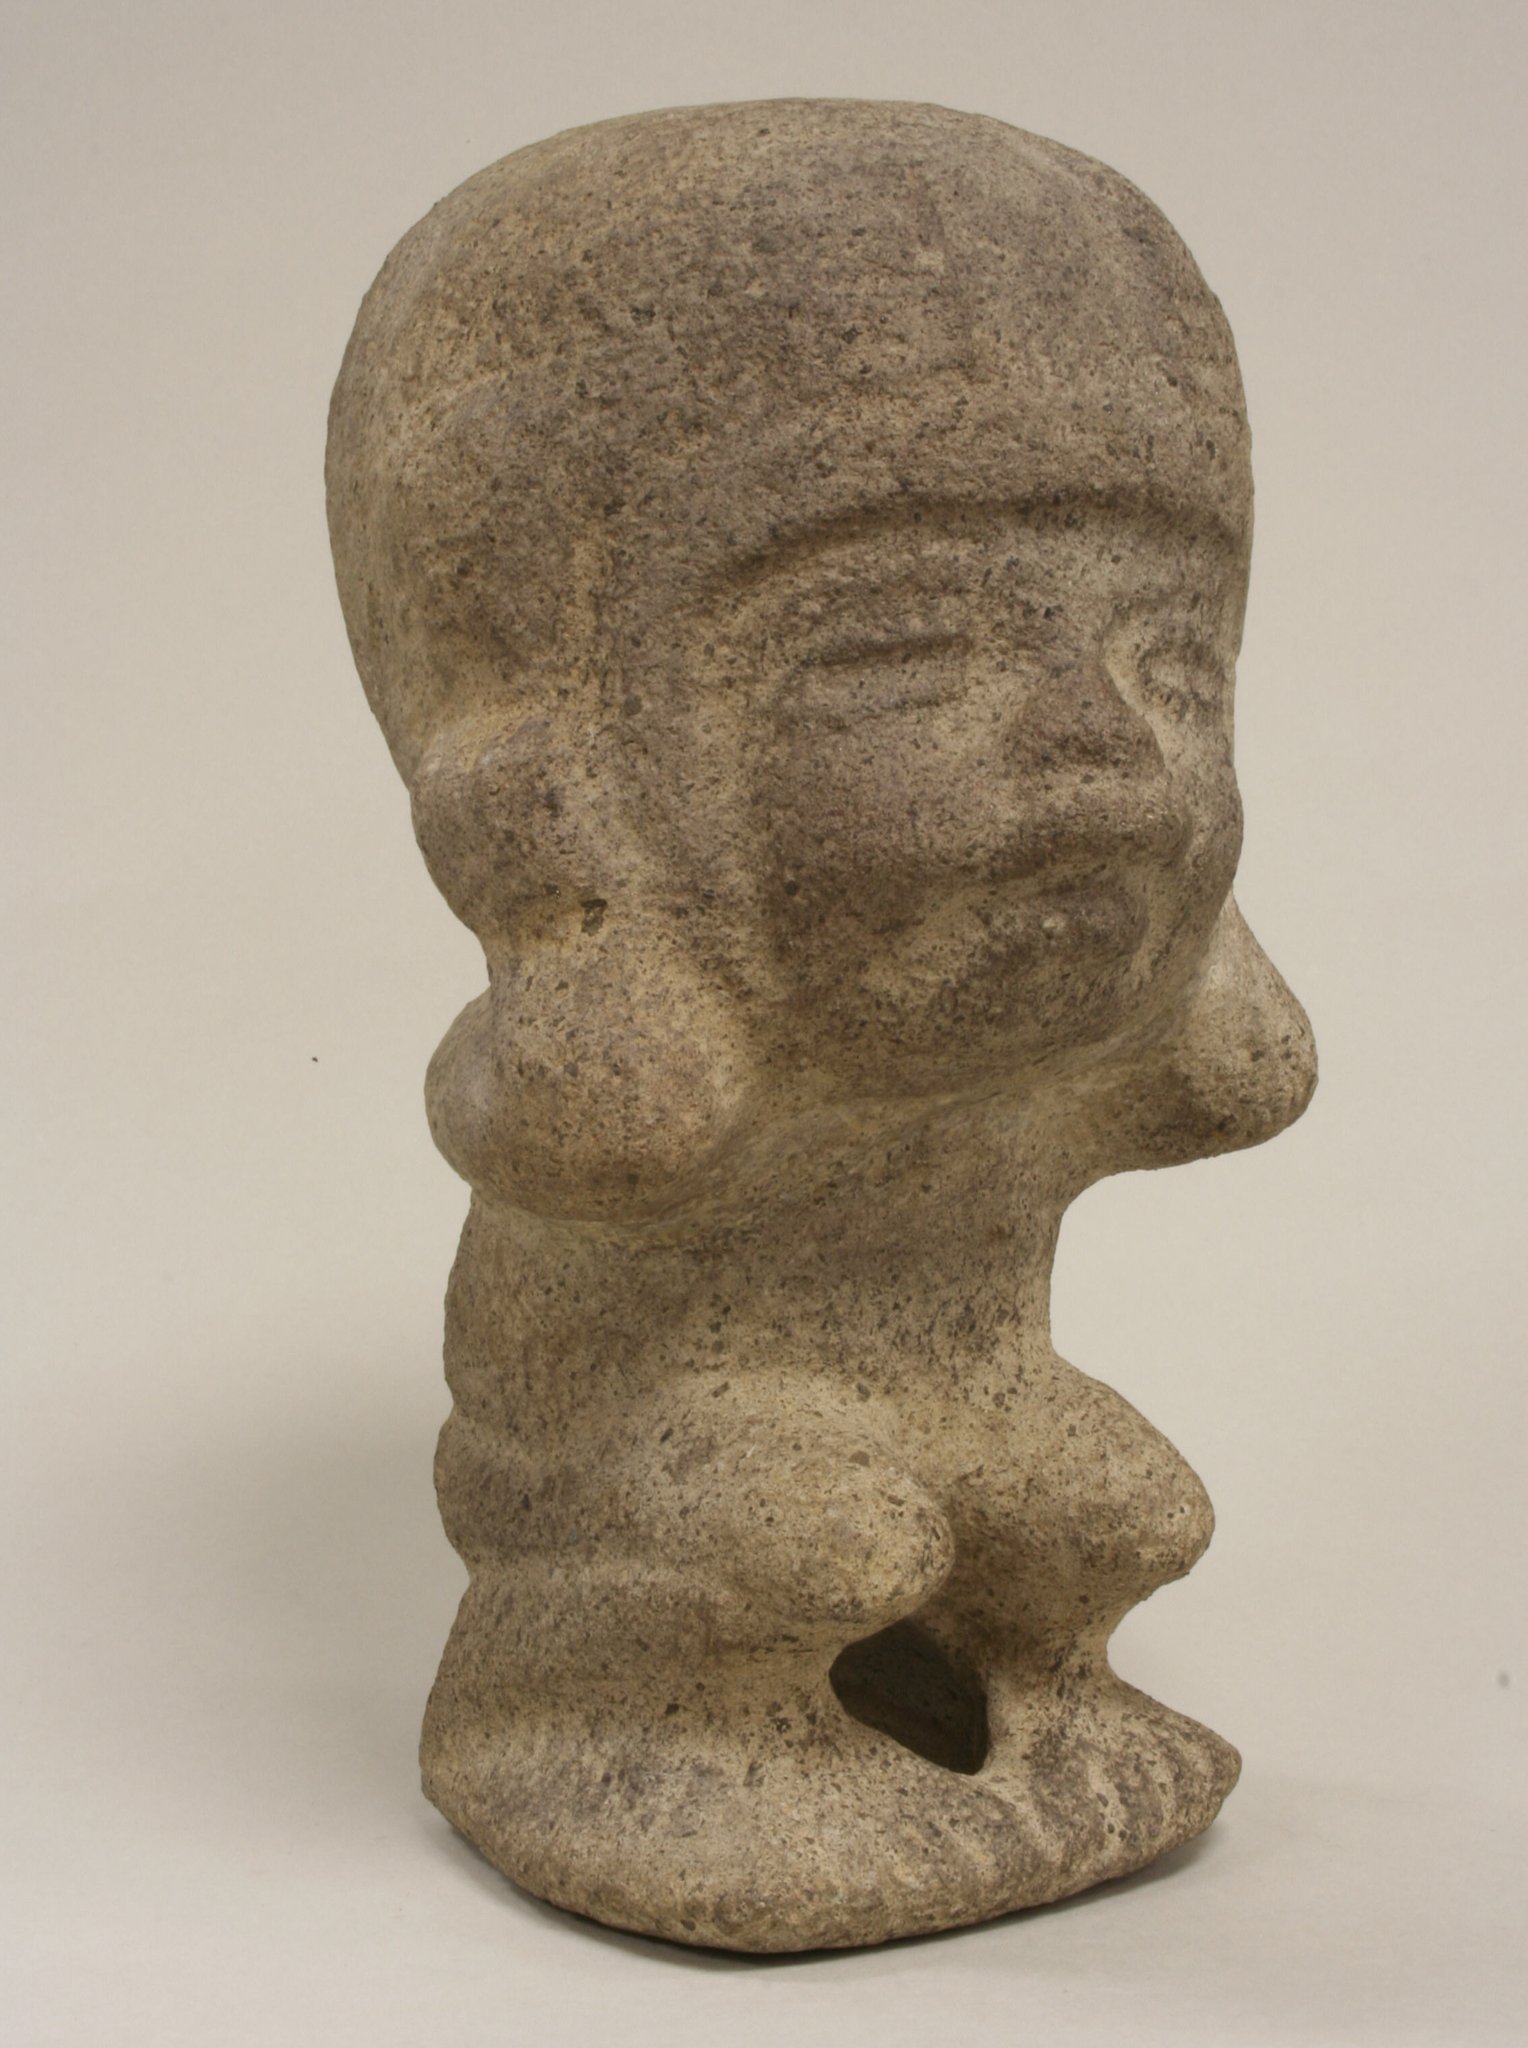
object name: figure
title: Crouching Figure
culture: olmec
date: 1000-301 BCE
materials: stone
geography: mexico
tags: human figures